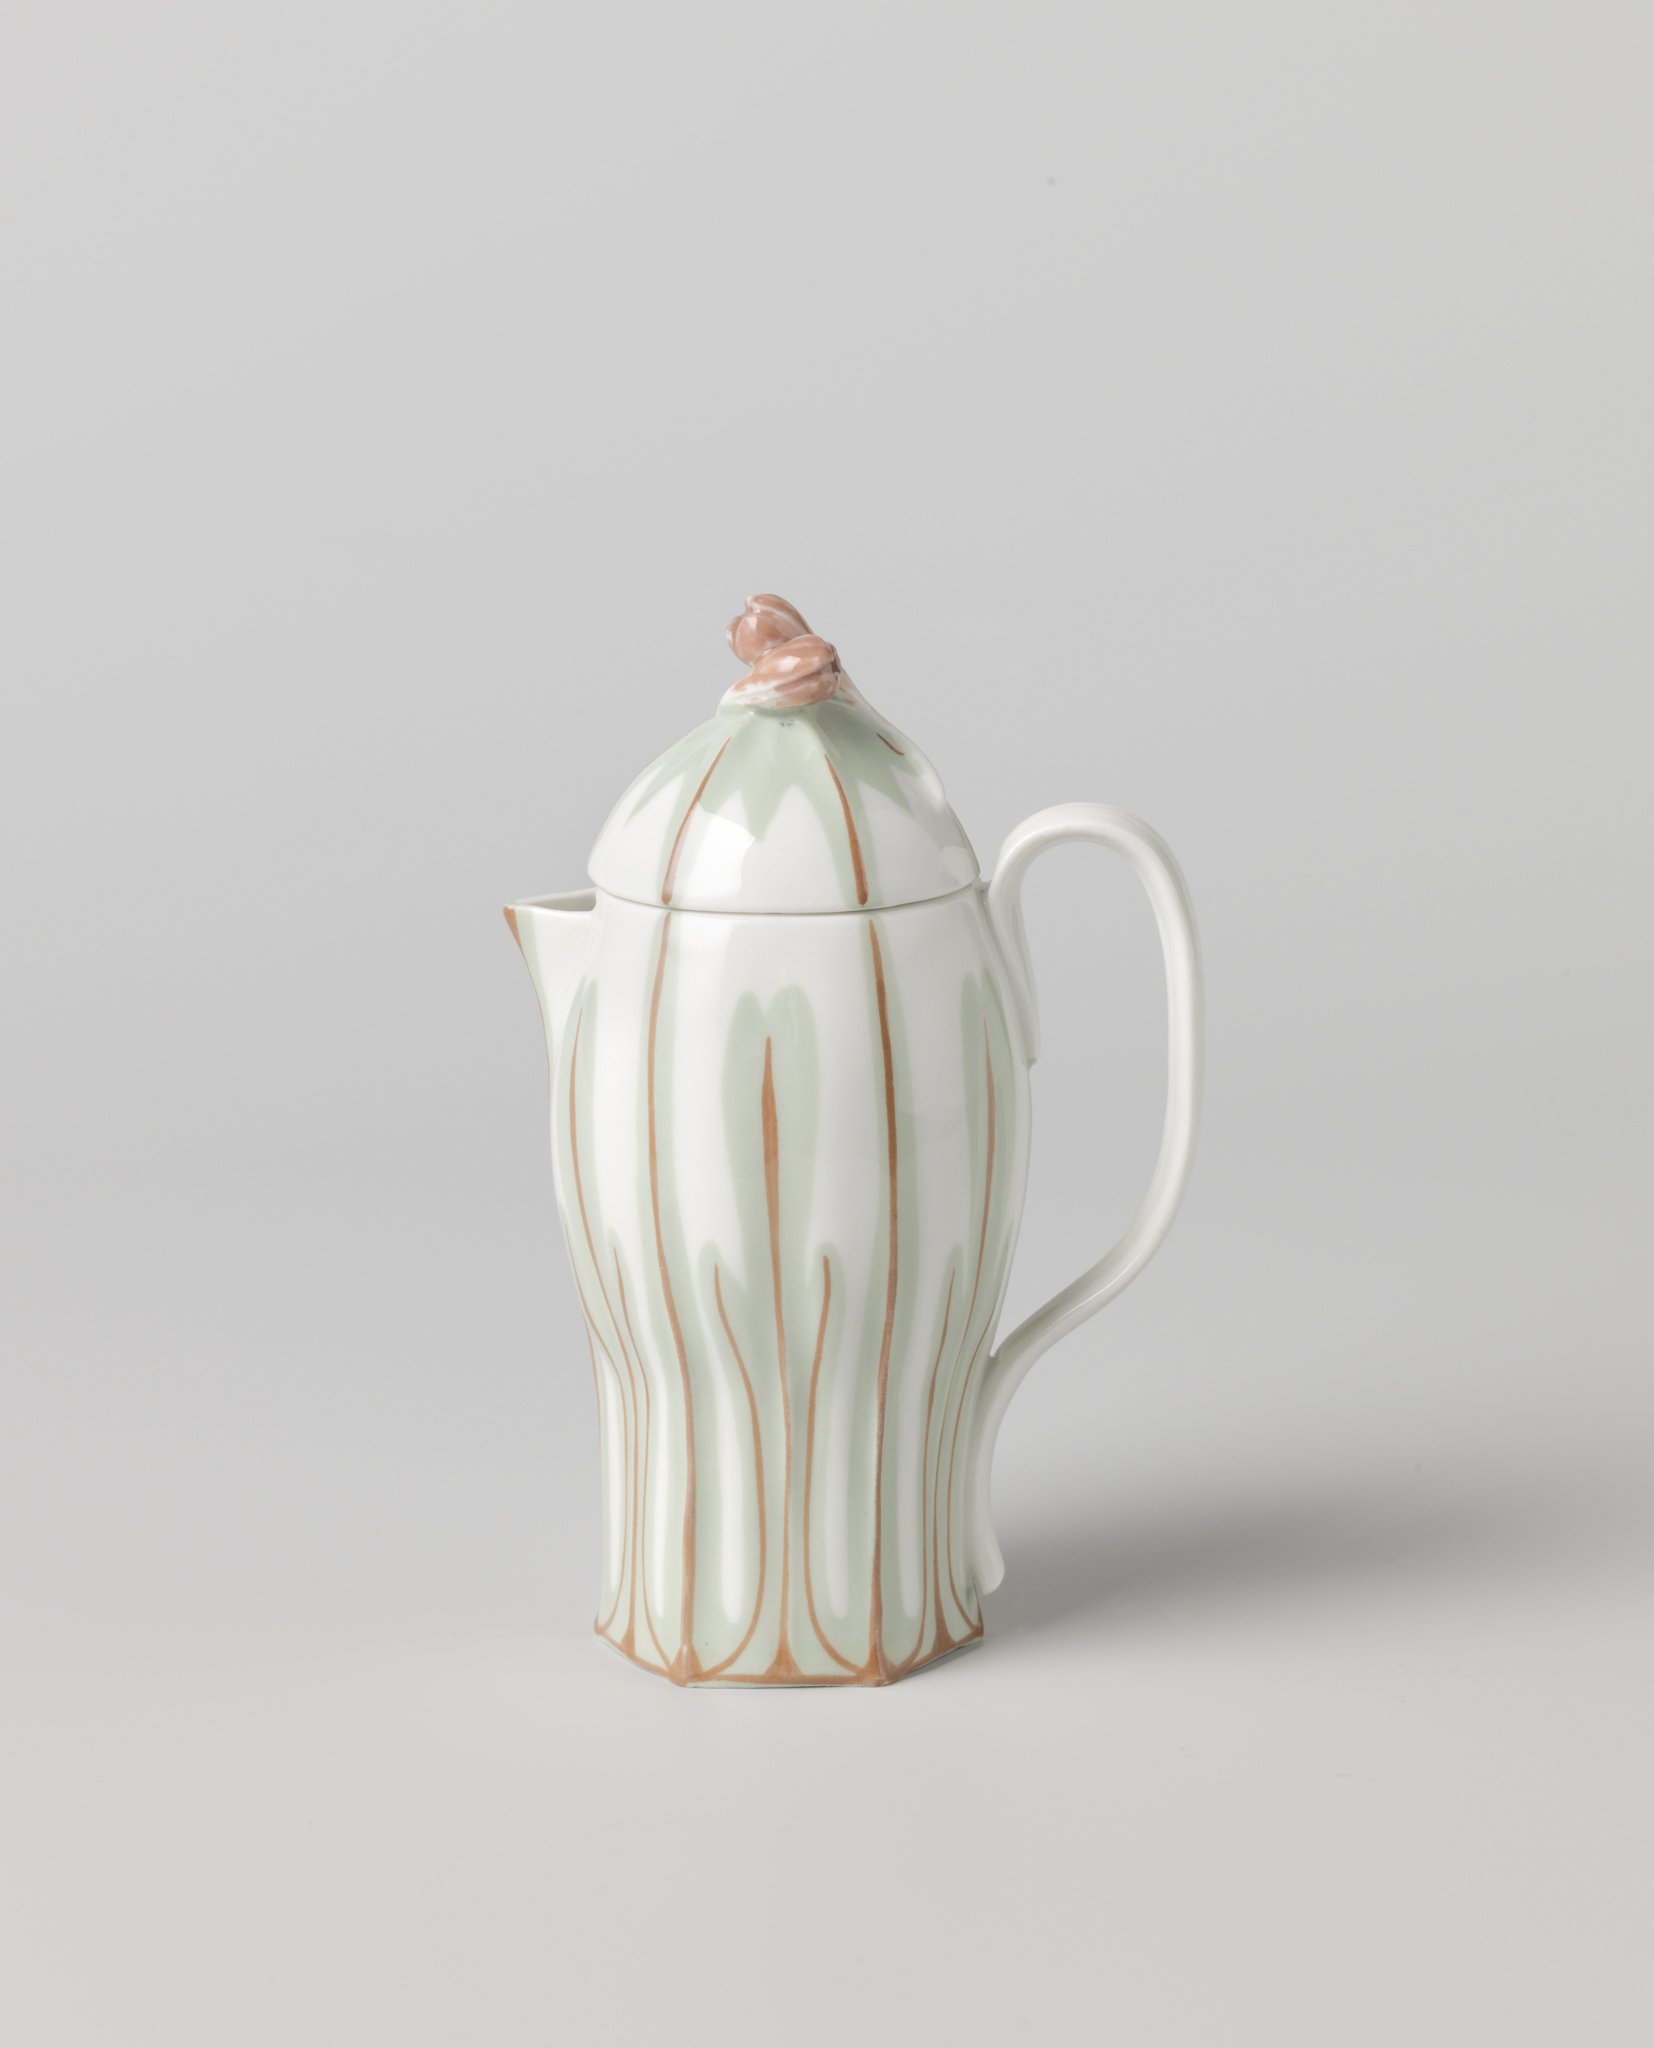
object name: eating drinking utensil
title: Melkkan beschilderd met het Krokus-decor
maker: konrad hentschel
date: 1896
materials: porcelain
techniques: painted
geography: meissen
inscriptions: mark: ‘71’, mark: ‘98’, model number: ‘Q109b’, factory mark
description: Melkkan van beschilderd porselein. De kan heeft een deksel en is beschilderd in groen en bruin. De kan is gemerkt.